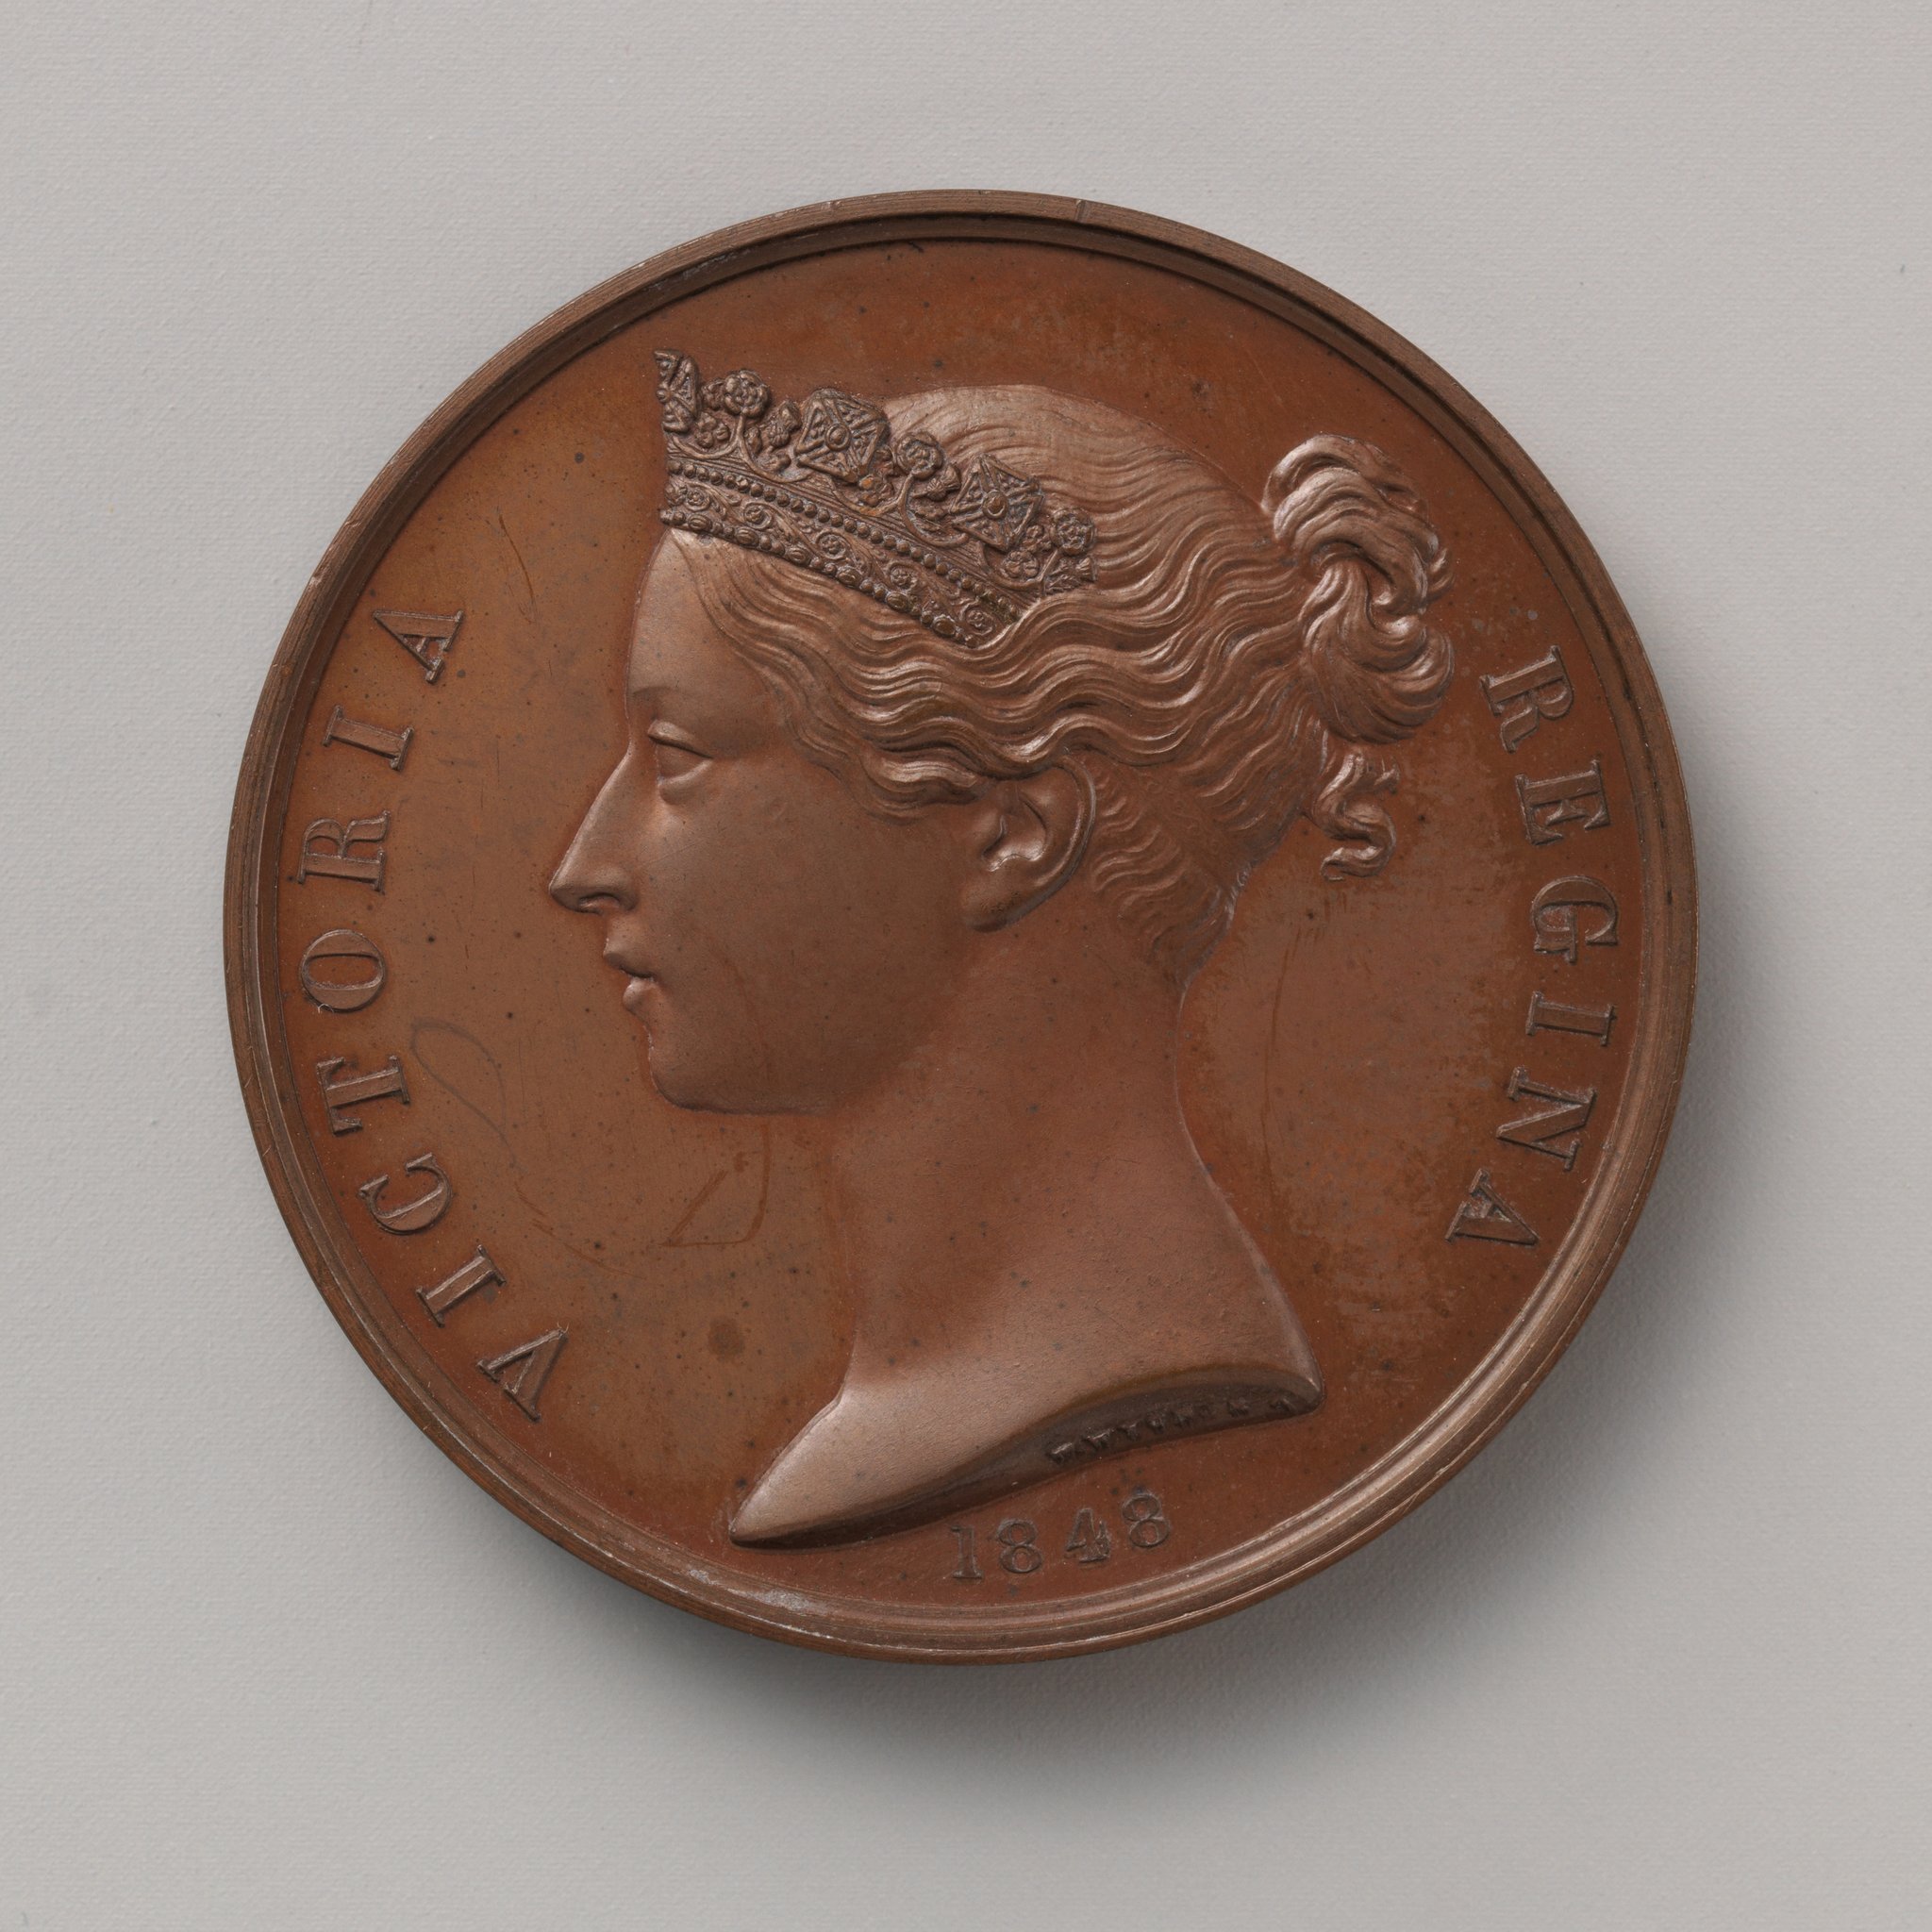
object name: medal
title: The Peninsular War Medal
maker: william wyon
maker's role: artist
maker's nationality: british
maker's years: 1795-1851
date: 1848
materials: bronze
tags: men,profiles